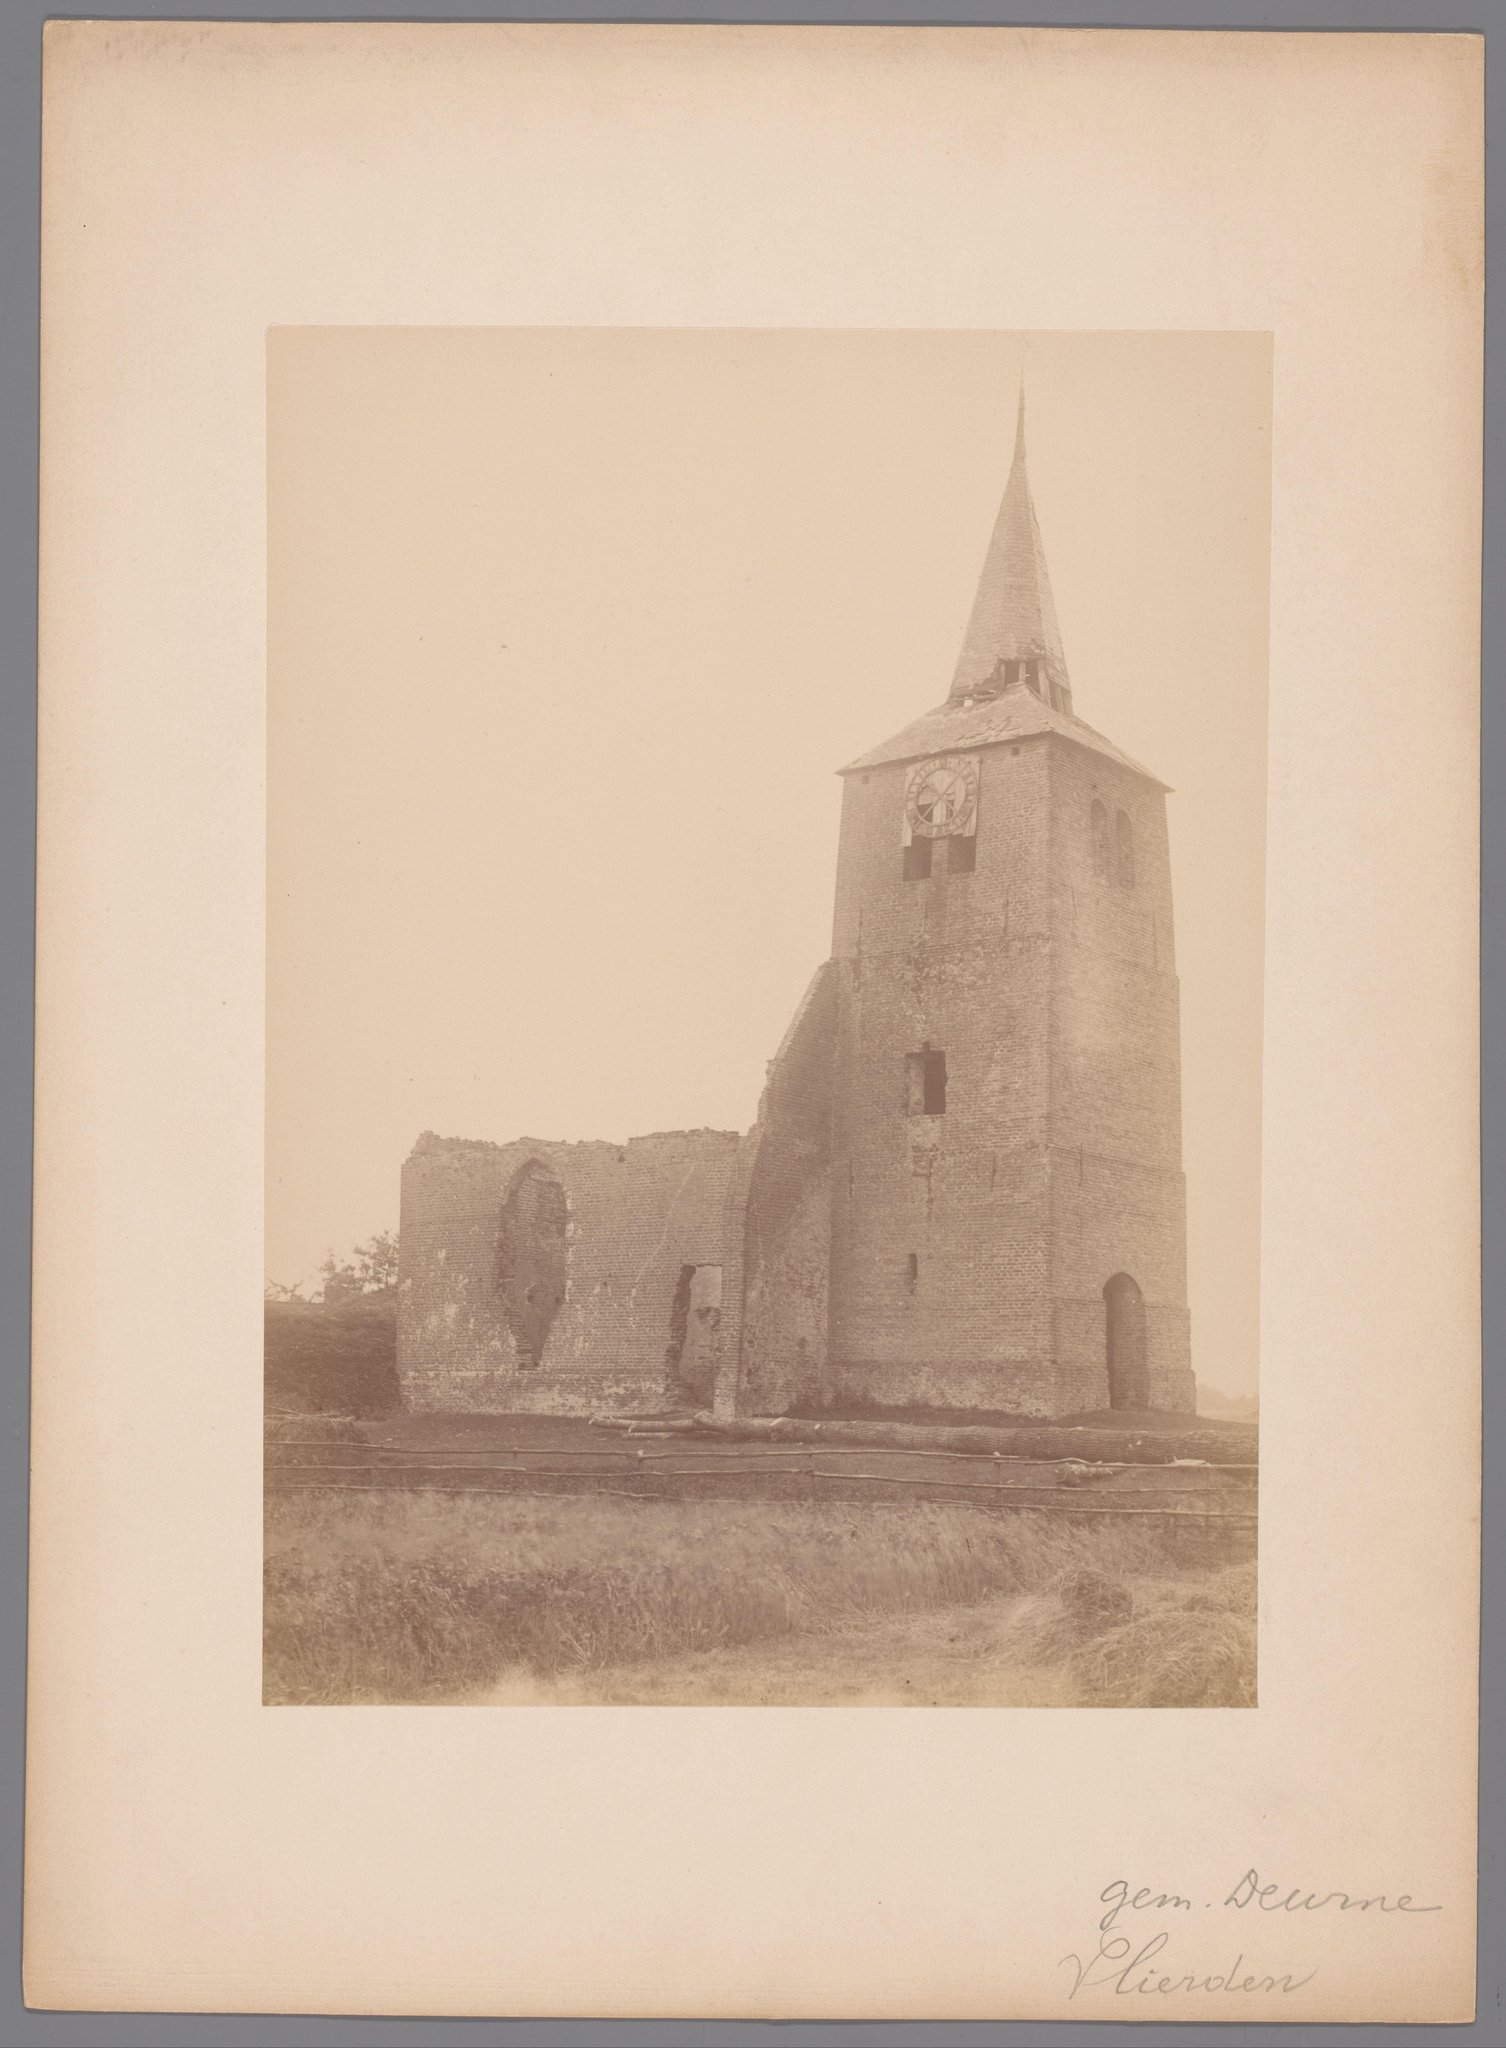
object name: photograph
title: Ruïne van de kerk te Vlierden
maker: anoniem (monumentenzorg)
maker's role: fotograaf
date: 1890-1920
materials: cardboard, photographic support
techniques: albumen print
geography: vlierden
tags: church (exterior), landscape with ruins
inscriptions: annotation: ‘Kerk (ruine) te Vlierden’, annotation: ‘gem. Deurne/ Vlierden’